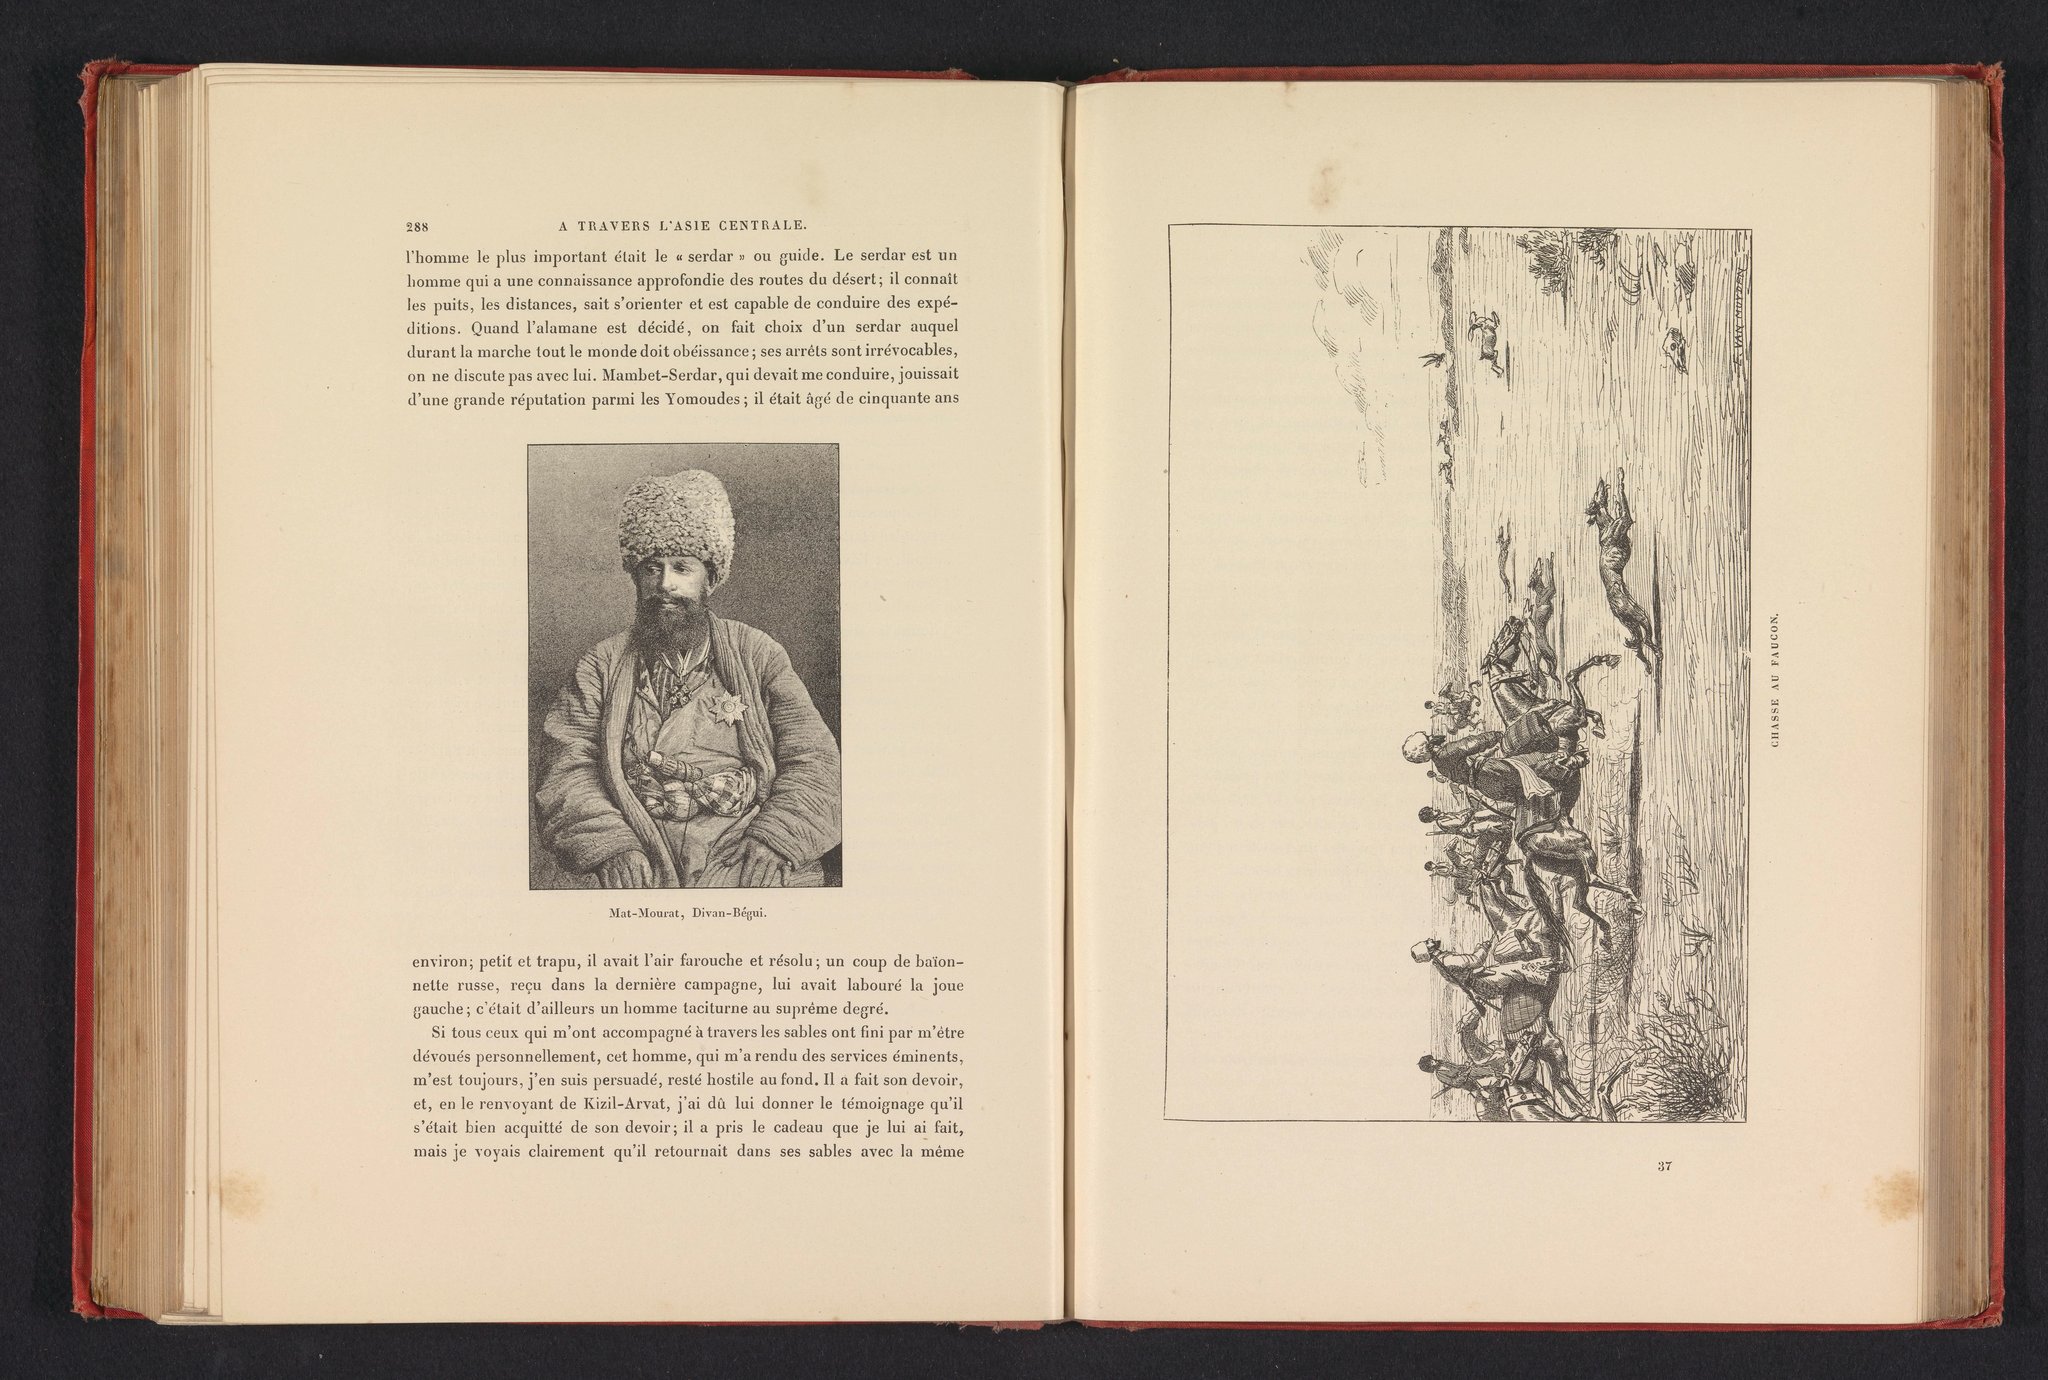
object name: page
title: Mat-Mourat, Divan-Bégui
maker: Anonymous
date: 1869-1885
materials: paper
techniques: autotype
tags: head-gear: turban